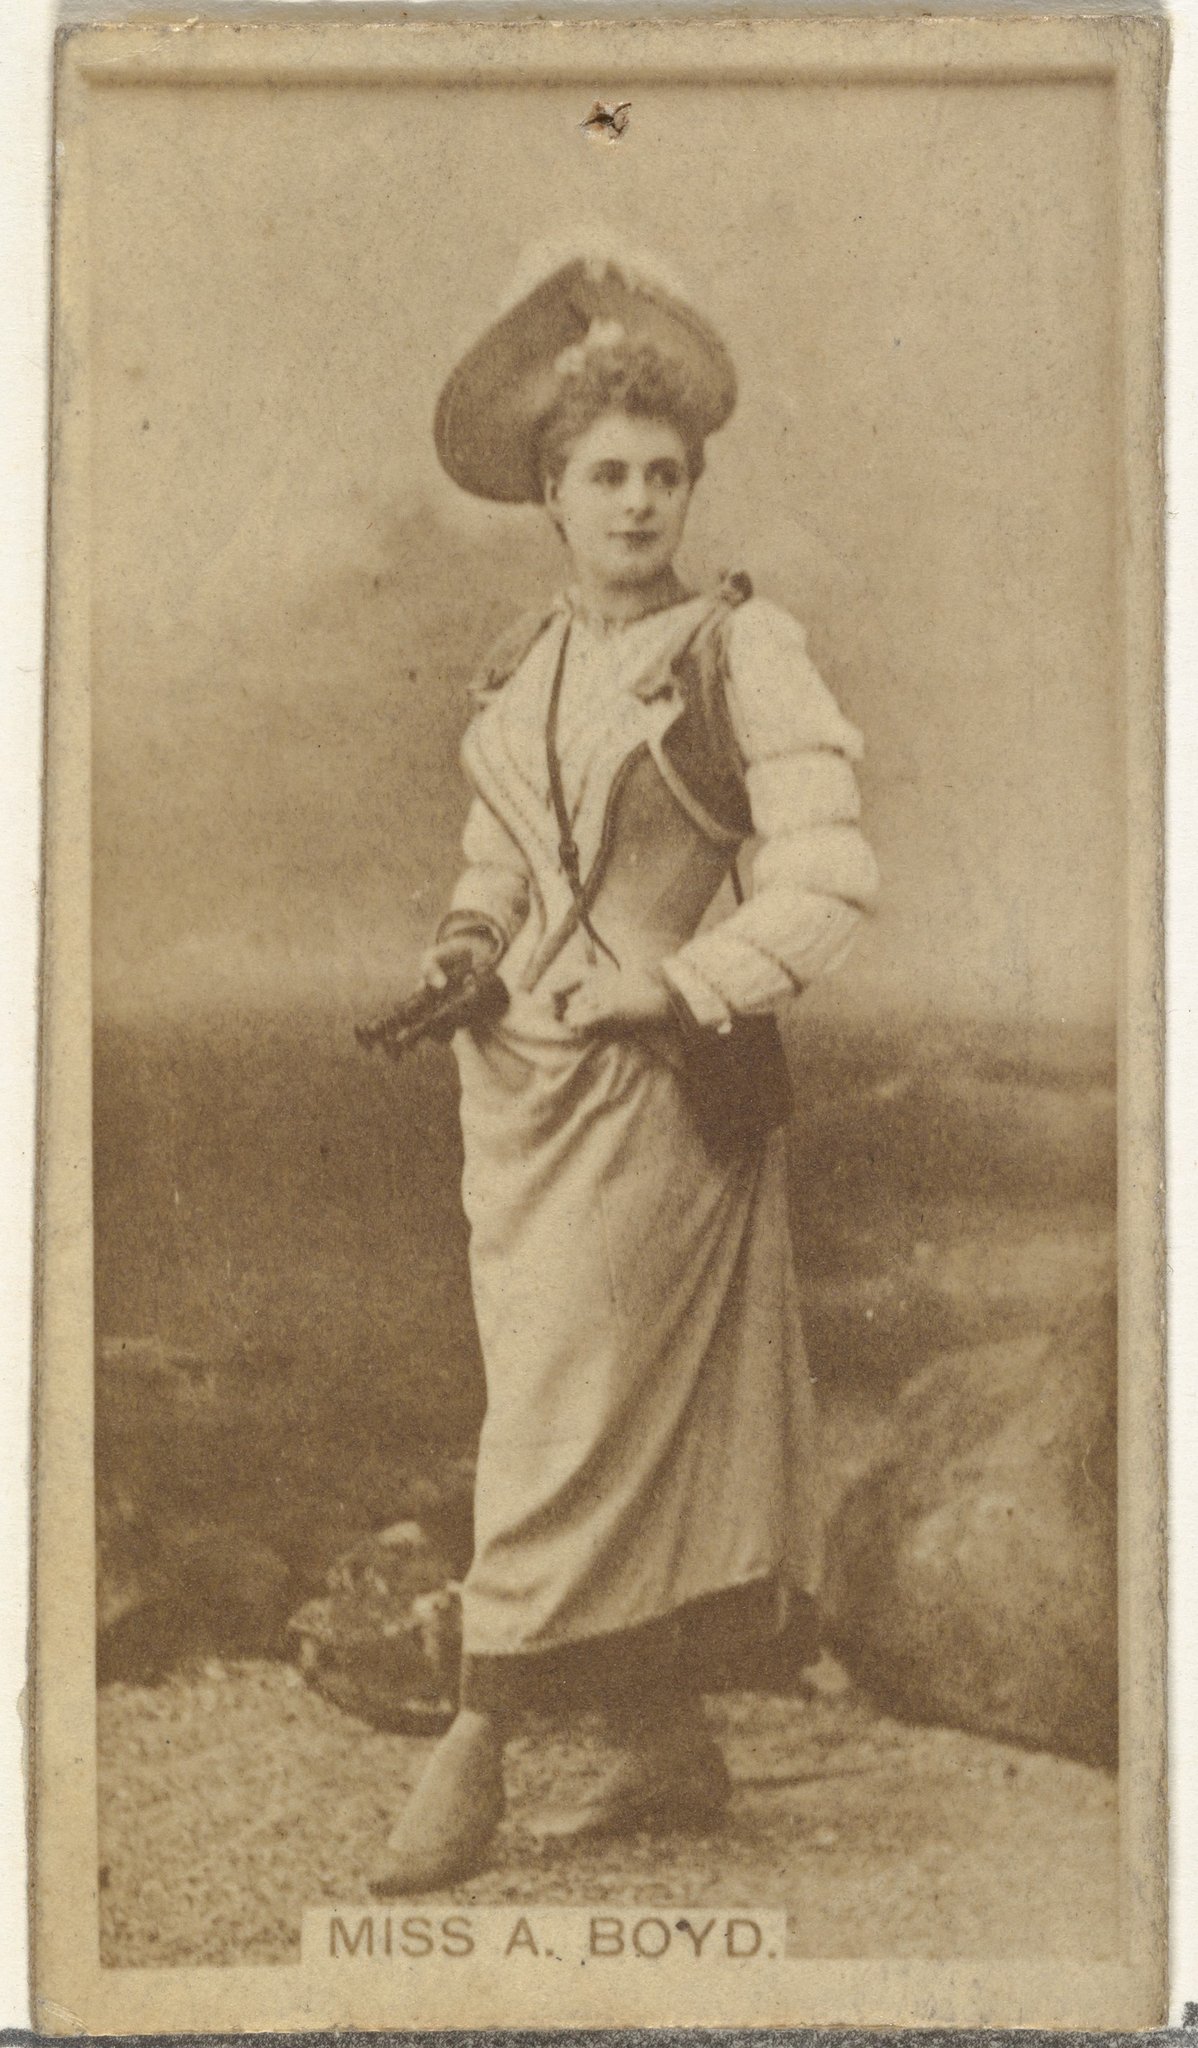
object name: photograph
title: Miss A. Boyd, from the Actors and Actresses series (N145-8) issued by Duke Sons & Co. to promote Duke Cigarettes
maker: w. duke, sons & co.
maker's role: publisher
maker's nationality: american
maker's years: 1870-1920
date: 1891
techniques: albumen silver print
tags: portraits,women,actresses